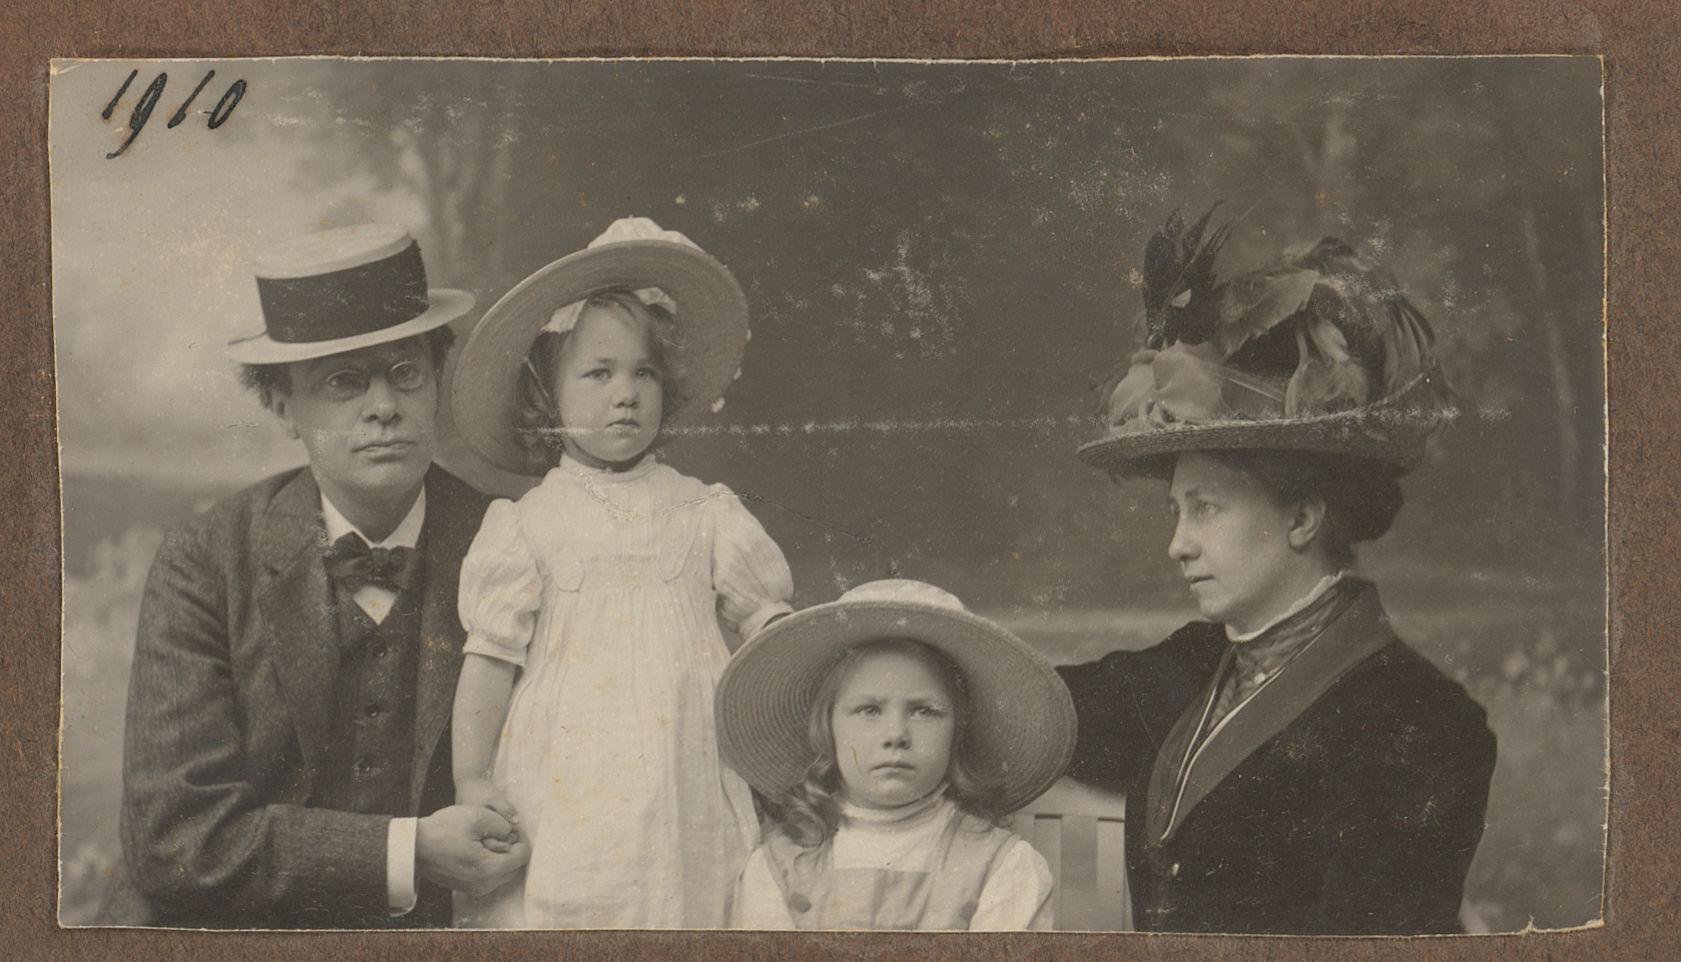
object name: photograph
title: Alphons Diepenbrock met vrouw en twee dochters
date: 1910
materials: photographic support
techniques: photography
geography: netherlands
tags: alphons diepenbrock, jonkvrouw wilhelmina elisabeth petronella cornelia de jong van beek en donk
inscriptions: date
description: Foto op bruin albumblad 3 van familiealbum van Alphons Diepenbrock.